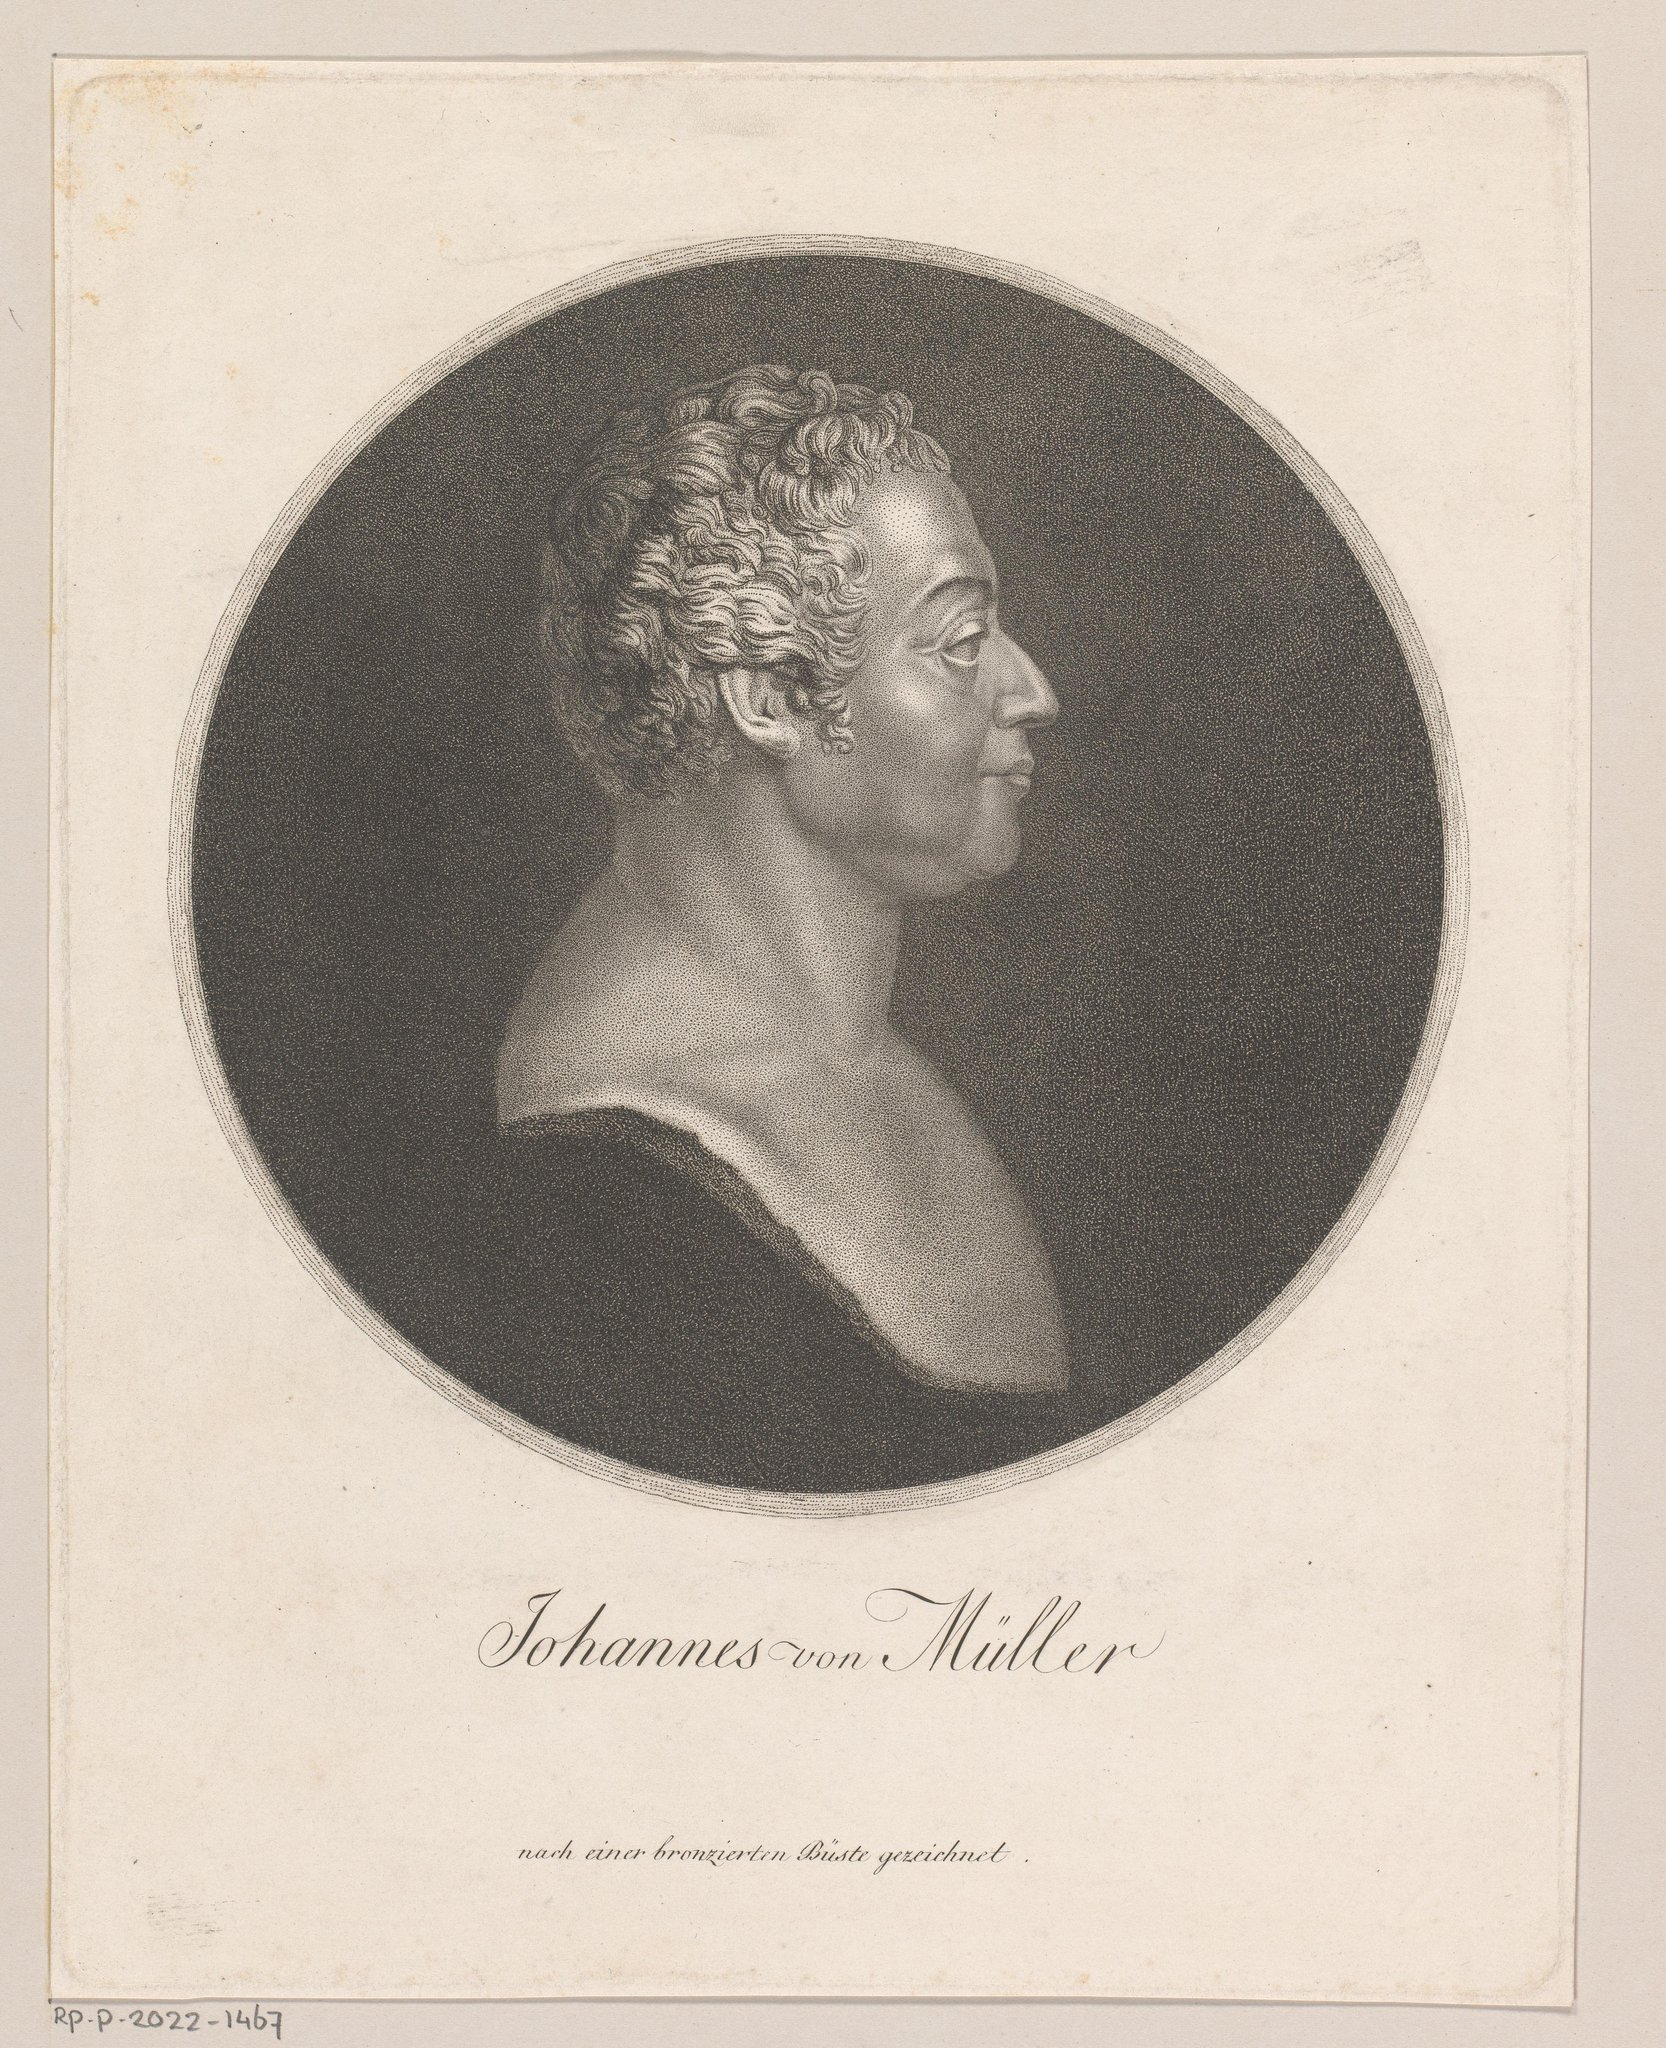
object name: print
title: Johannes von Müller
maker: Anonymous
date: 1780-1900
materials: paper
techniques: engraving, etching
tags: further education (+ portrait of teacher, professor), historical persons